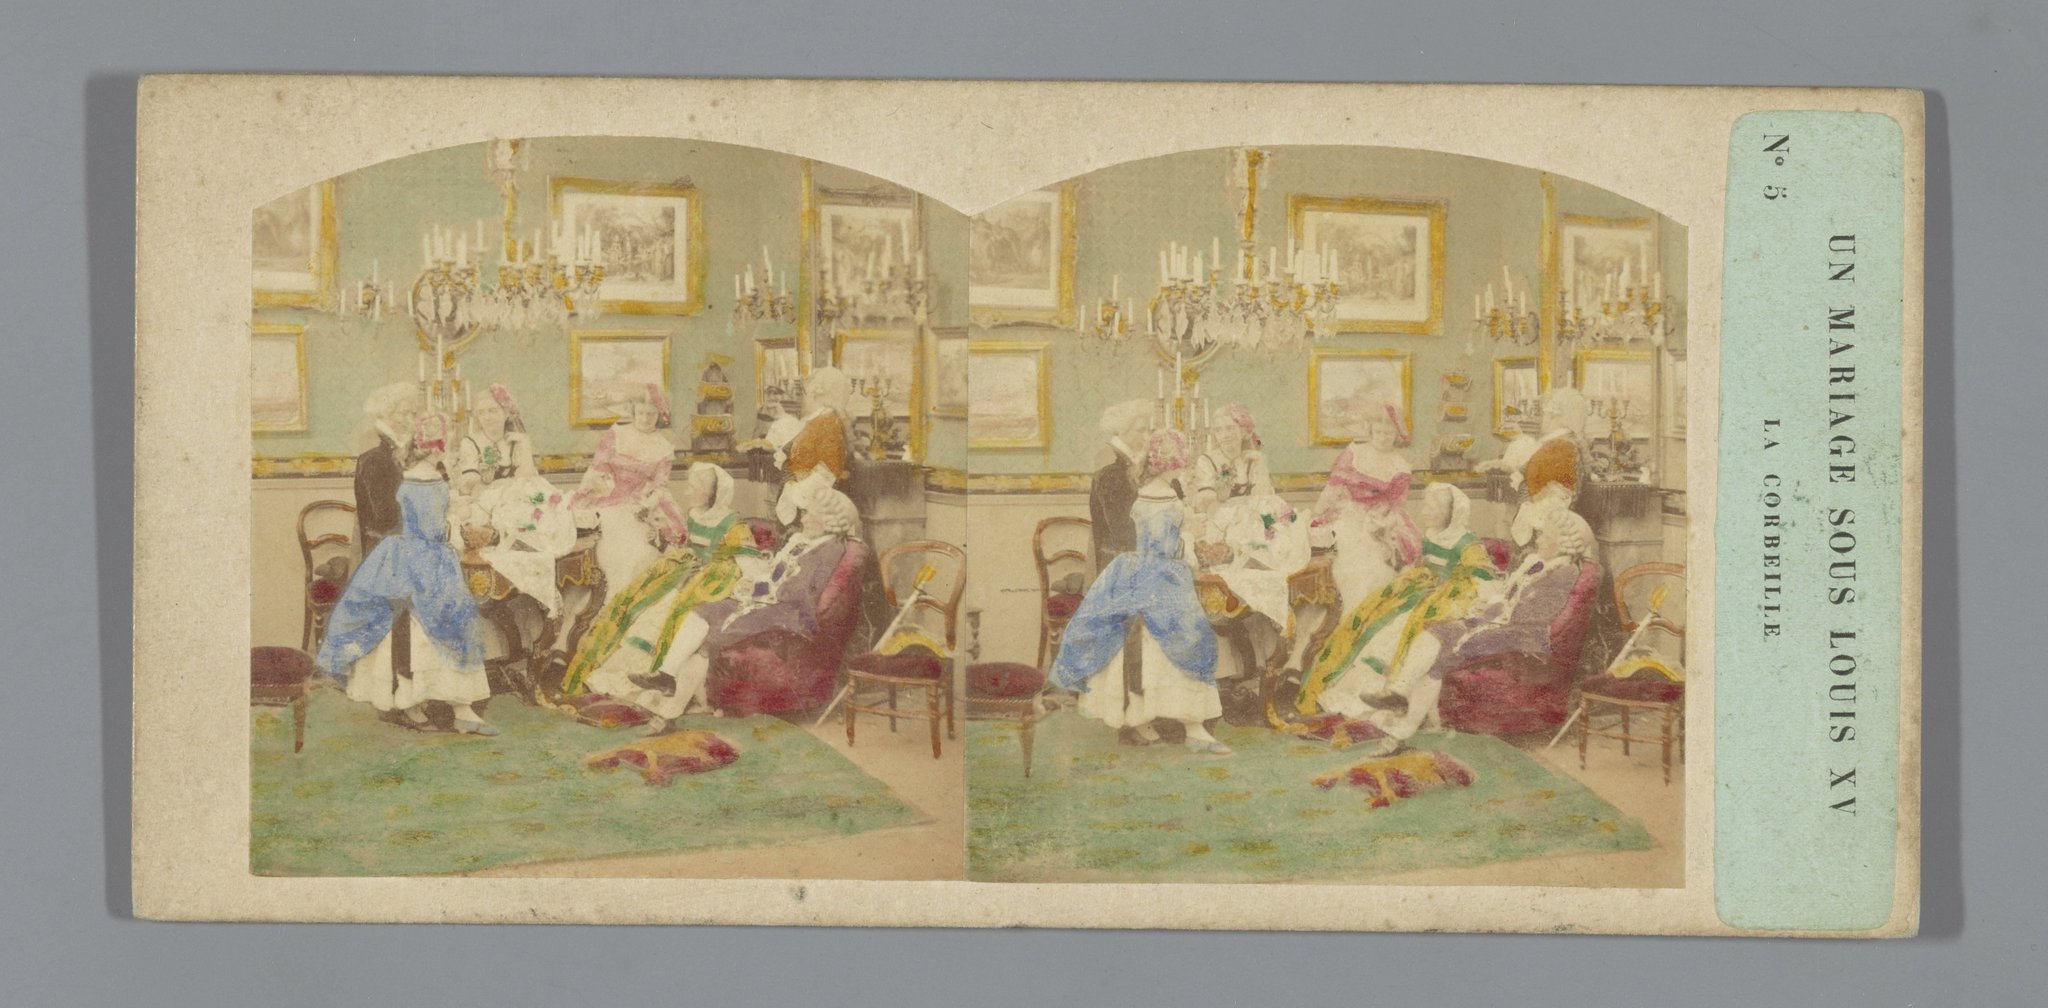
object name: stereograph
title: La Corbeille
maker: Anonymous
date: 1852-1863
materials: cardboard, paper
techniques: albumen print, hand coloring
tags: royal household; courtiers, retinue, train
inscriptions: number: ‘5’, inscription: ‘cl 100’, retailer's mark: ‘Feldbrugge & Co./ Groningen’